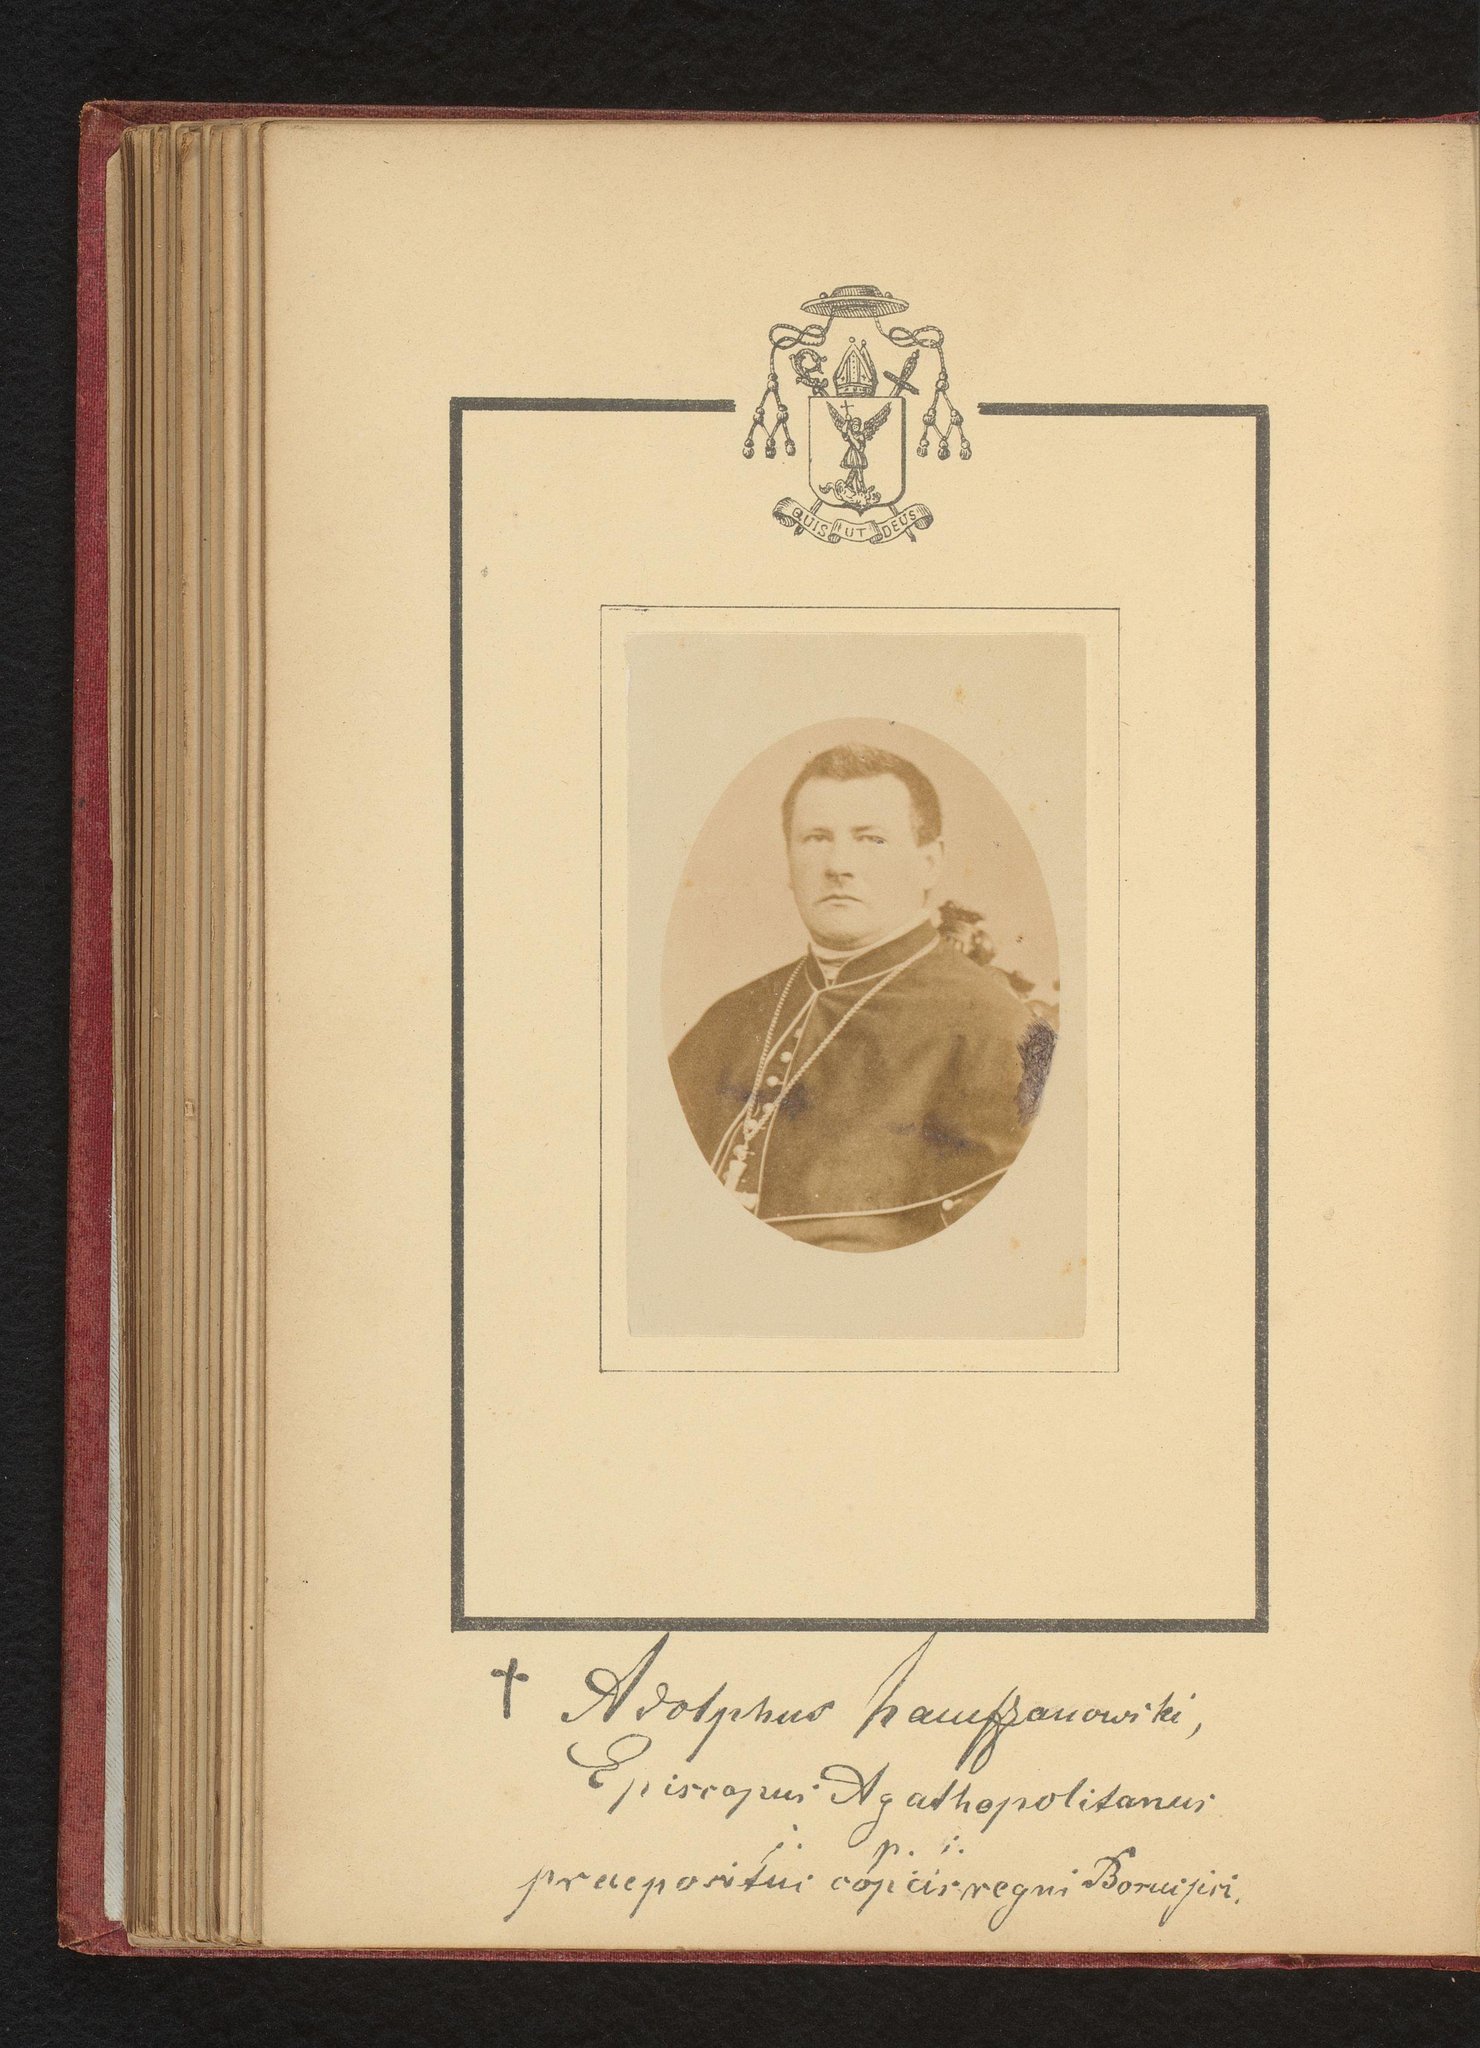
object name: photograph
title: Portret van bisschop Franz Adolf Namszanowski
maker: Anonymous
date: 1863-1873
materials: photographic support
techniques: albumen print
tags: archbishop, bishop, etc. (roman catholic)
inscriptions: inscription: ‘Adolphus [...] Episcopus Agathopolitanus praepor[...]’